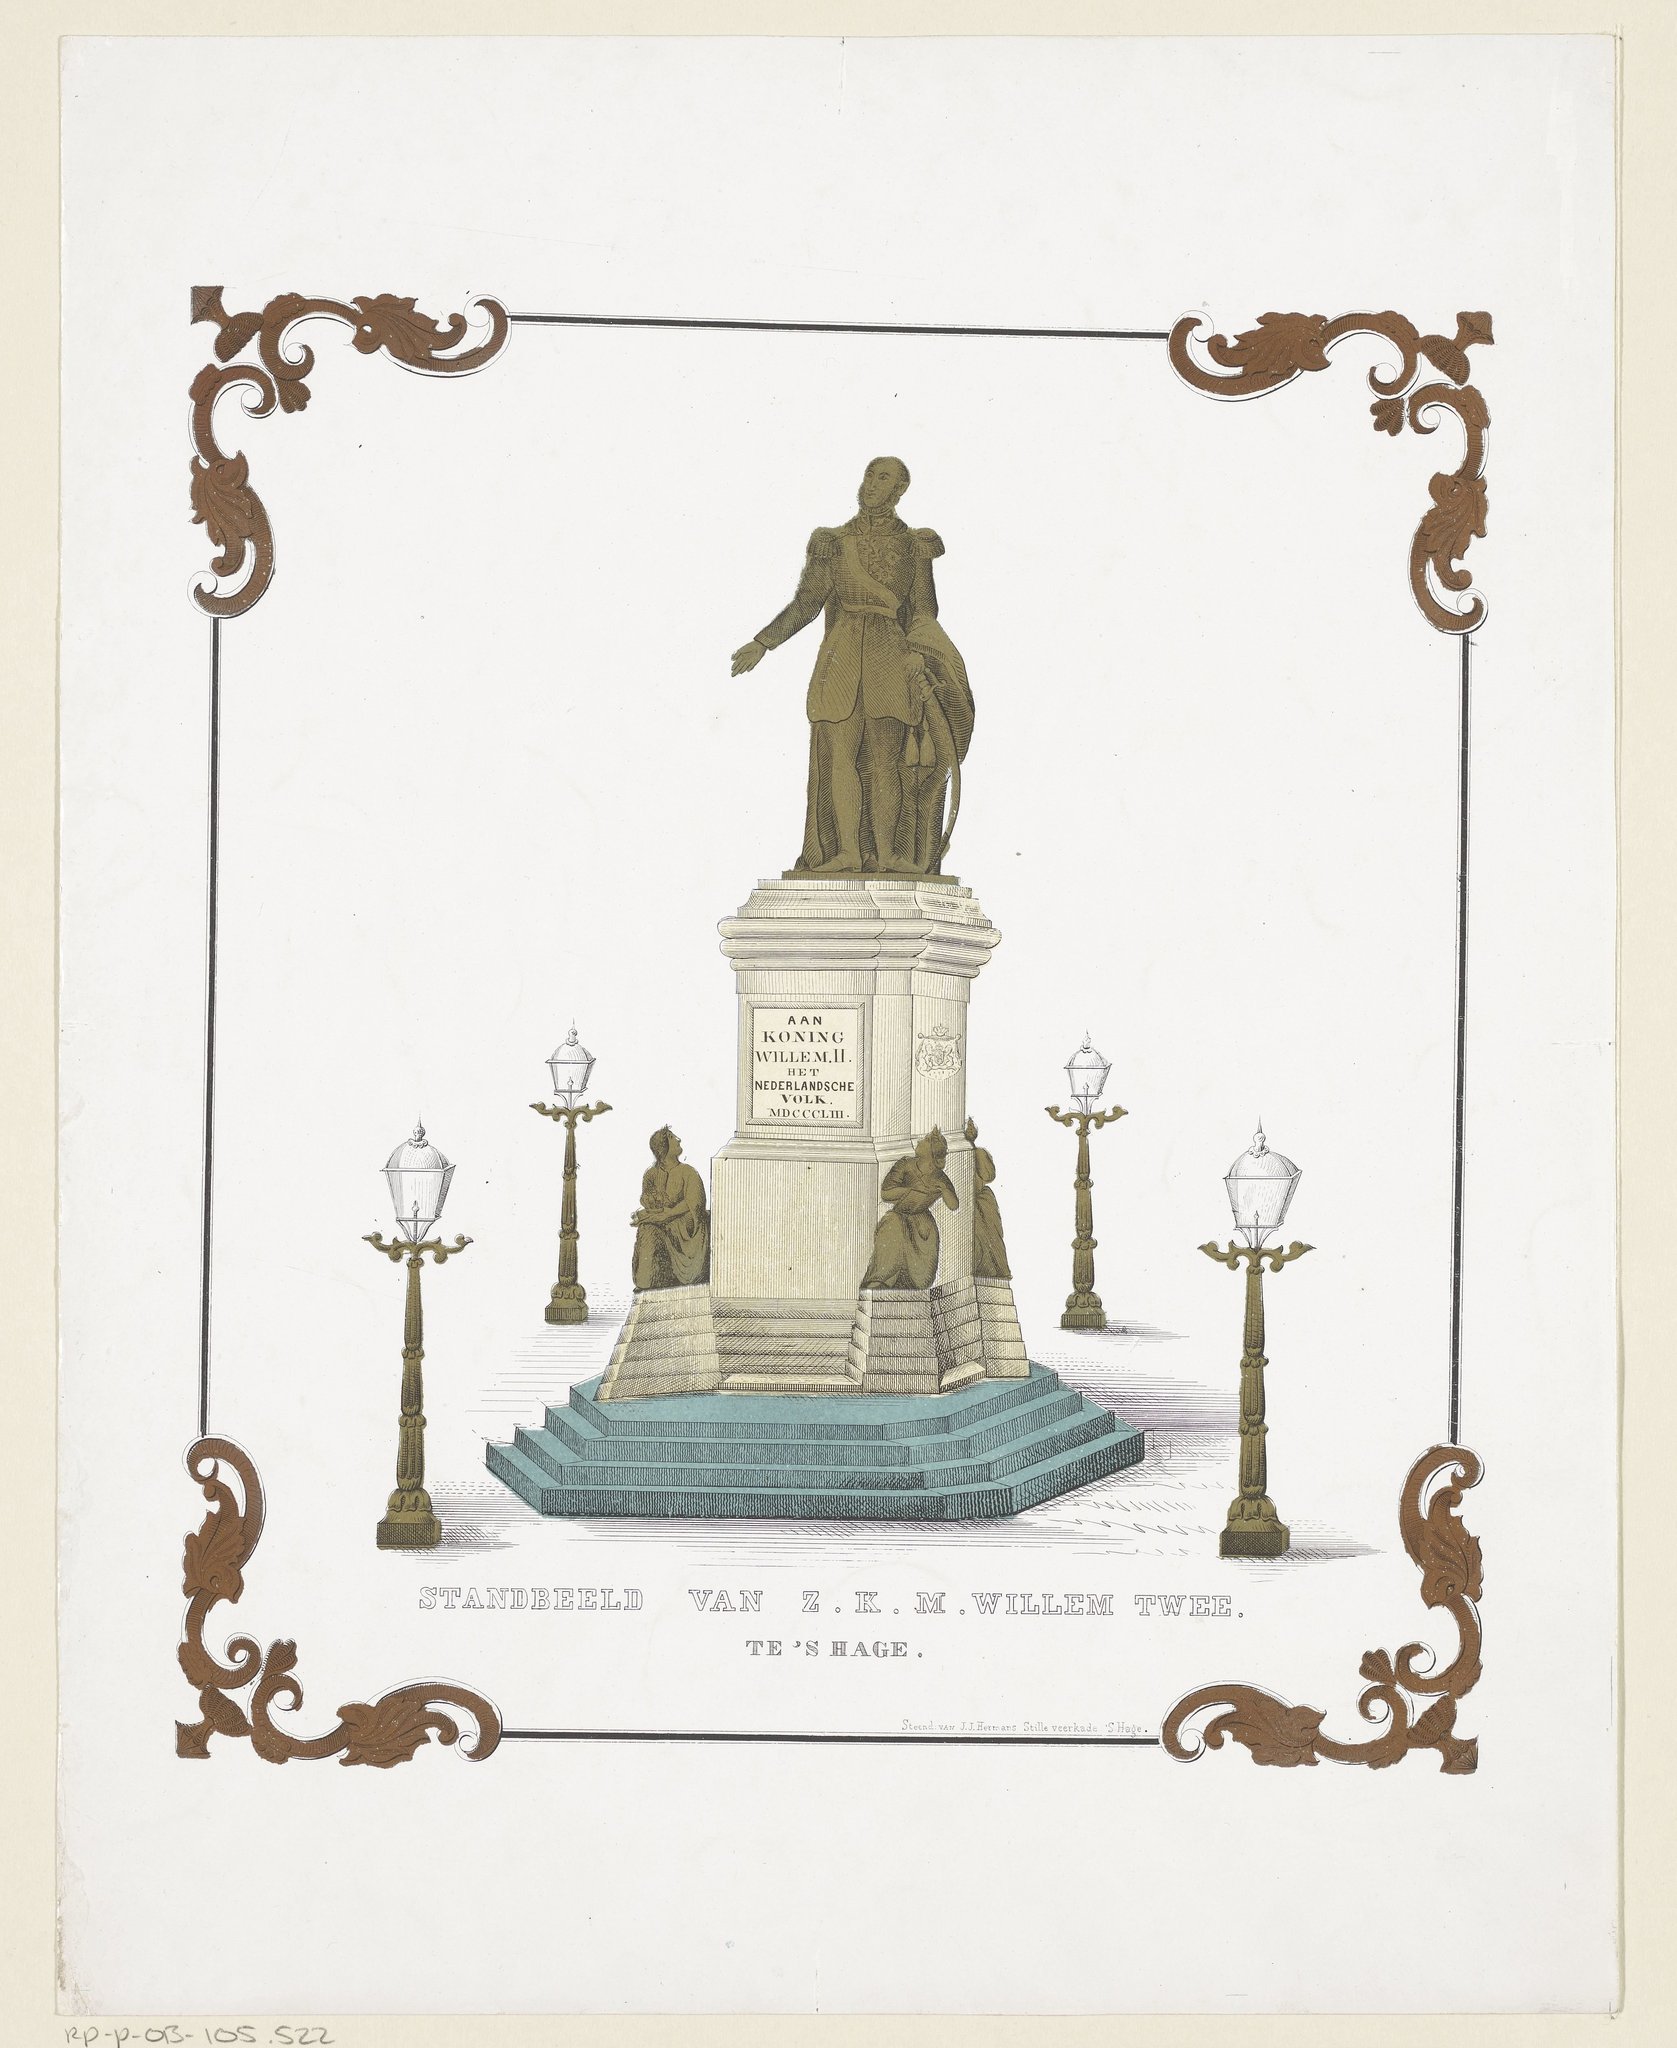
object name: print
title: Standbeeld van Willem II, koning der Nederlanden, op het Buitenhof te Den Haag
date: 1854-1899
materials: paper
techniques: lithograph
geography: netherlands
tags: the hague, william ii of the netherlands, monument, statue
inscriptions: collector's mark: Lugt 2165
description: Standbeeld van Willem II door Eduard François Georges op het Buitenhof te Den Haag. In de ondermarge twee regels Nederlandse tekst. Geheel in een geornamenteerde rechthoek.